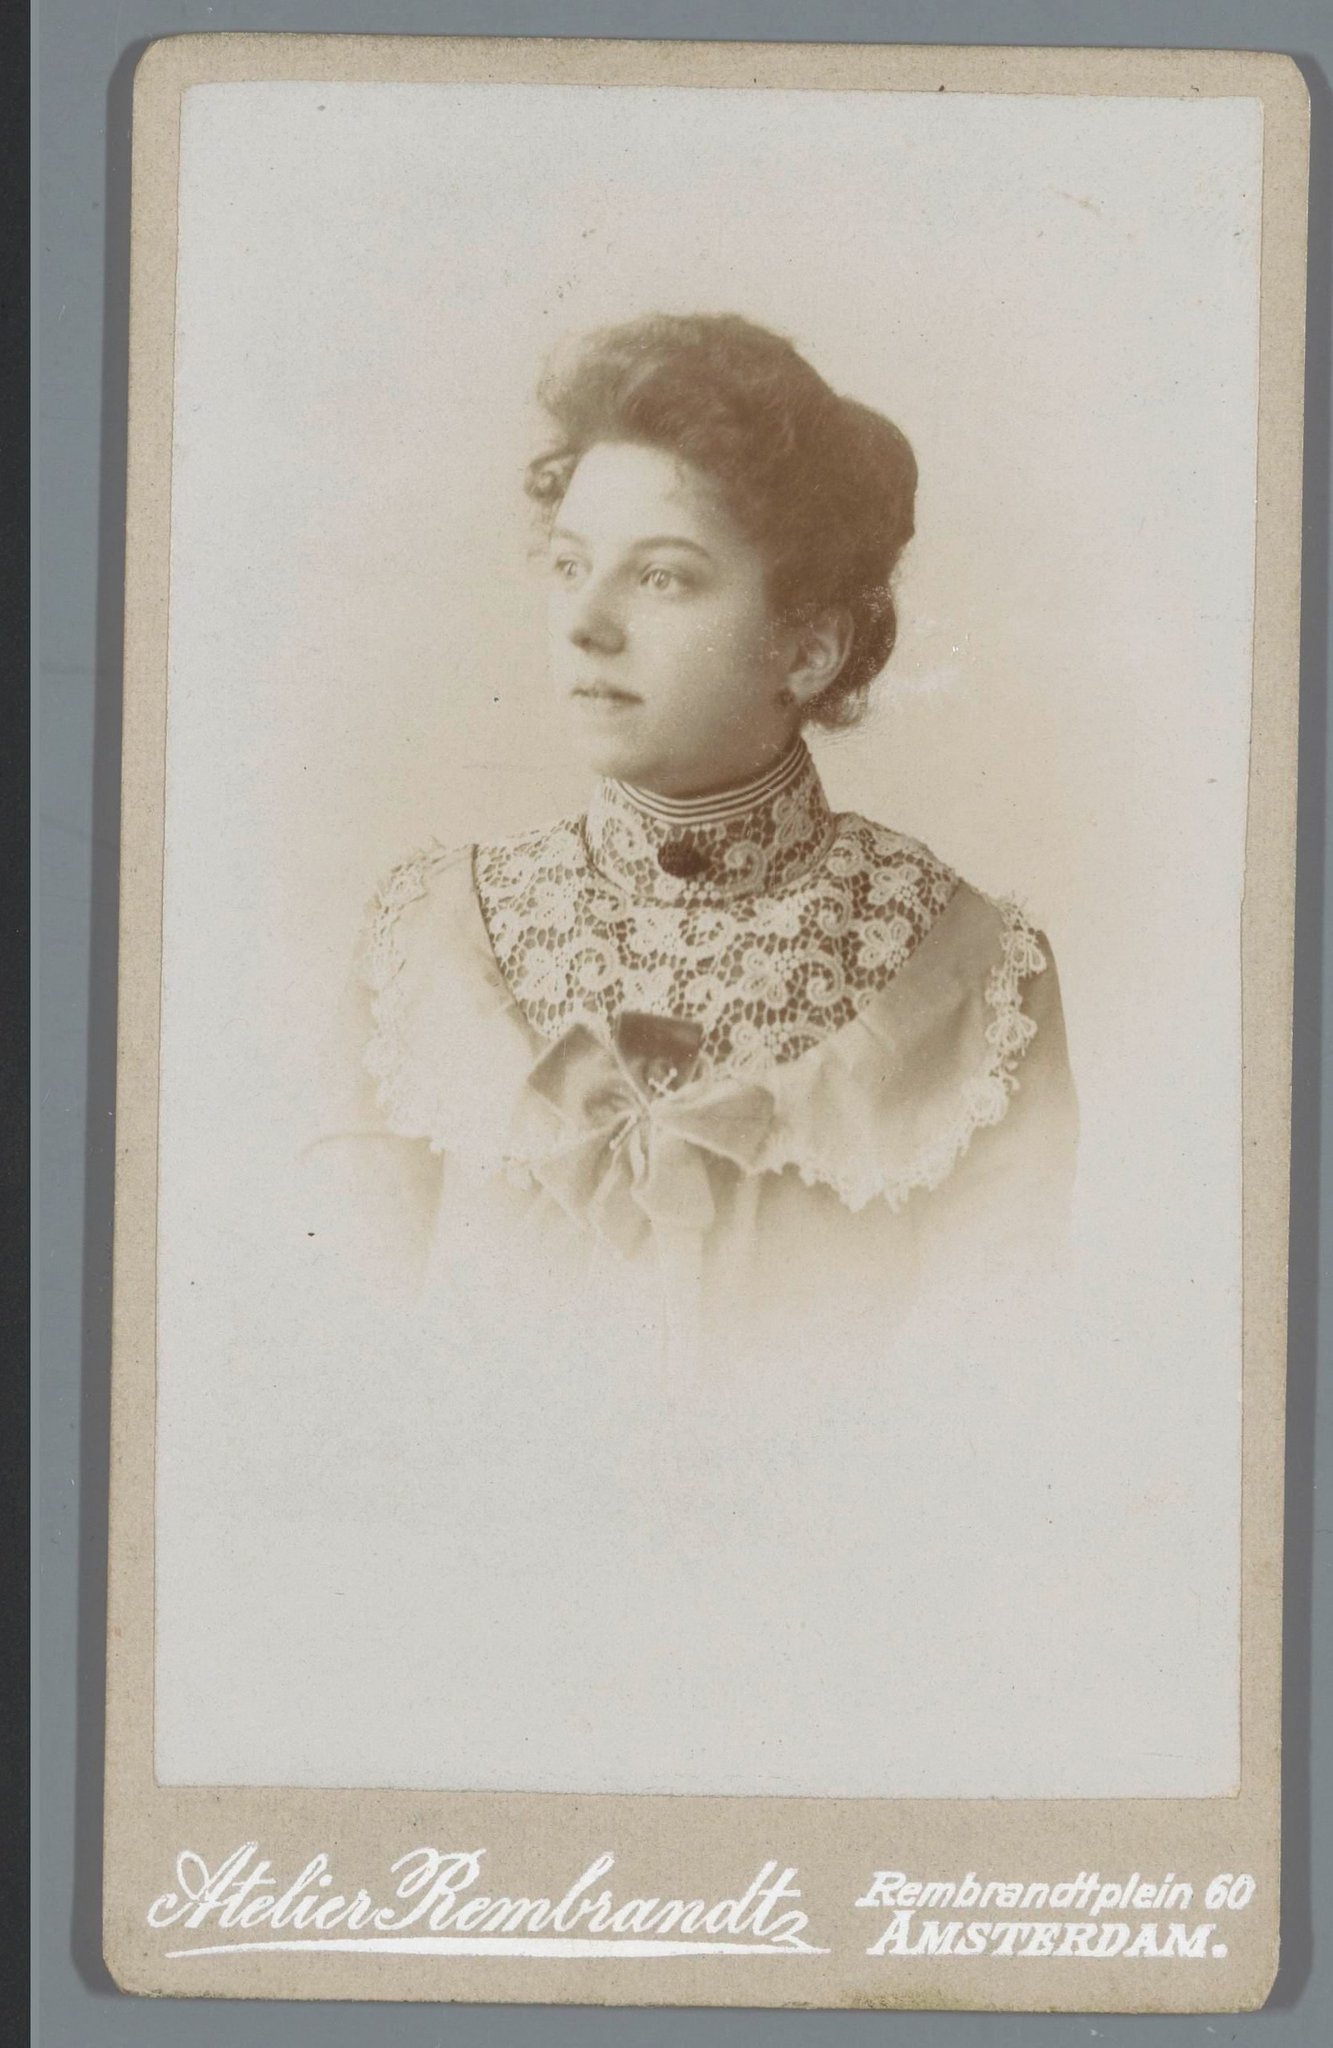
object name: carte de visite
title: Portret van een onbekende vrouw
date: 1890-1911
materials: cardboard, photographic support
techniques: gelatin silver print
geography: amsterdam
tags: historical persons - bb - woman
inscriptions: inscription: ‘No........../ PHOTOGRAPHIE/ ARTISTIQUE/ Rembrandt/ AMSTERDAM/ Rembrandtplein 60./ Specialiteit in vergrootingen/ tot levensgroot./ DE PLAAT BLIJFT TER NABESTELLING/ BEWAARD./ TRAPP & MÜNCH, BERLIN.’